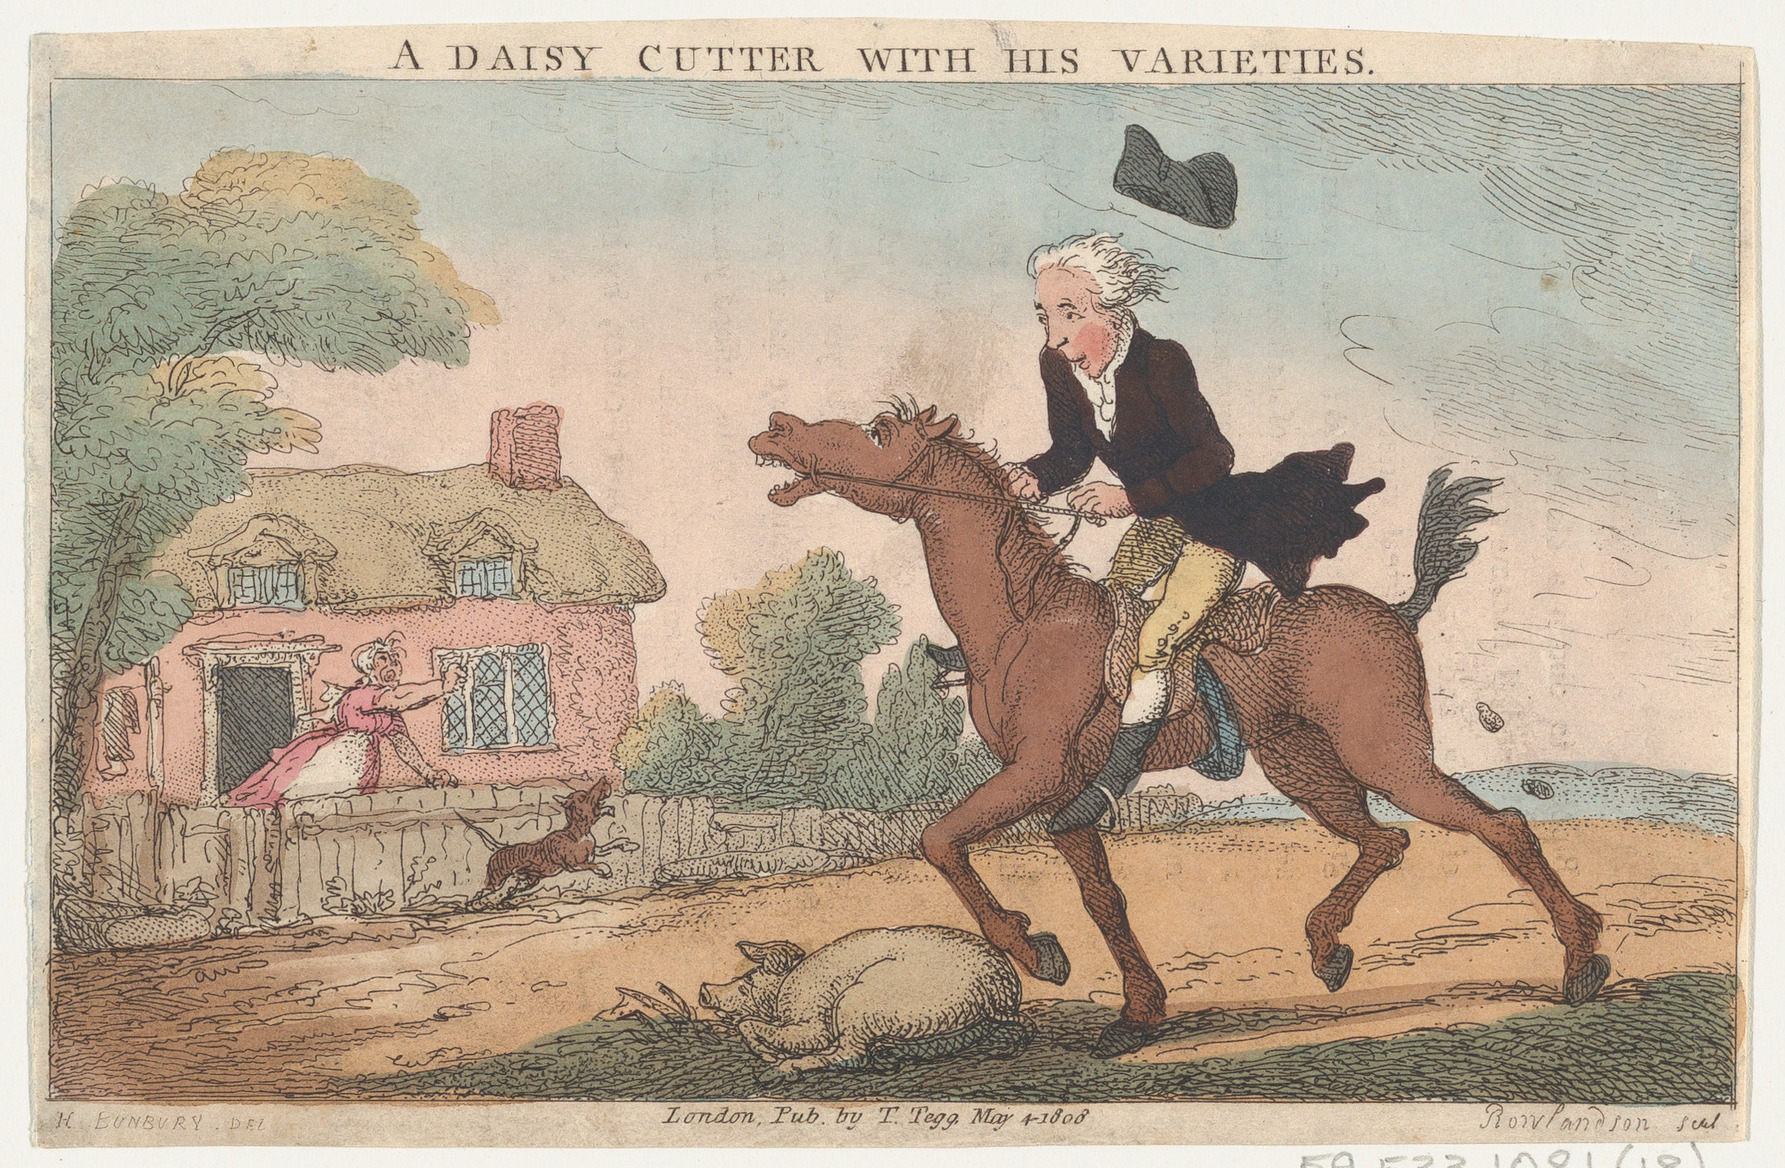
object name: print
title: A Daisy Cutter with His Varieties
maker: thomas rowlandson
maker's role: artist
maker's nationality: british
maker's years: 1757-1827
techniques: etching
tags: satire,men,women,dogs,horses,pigs